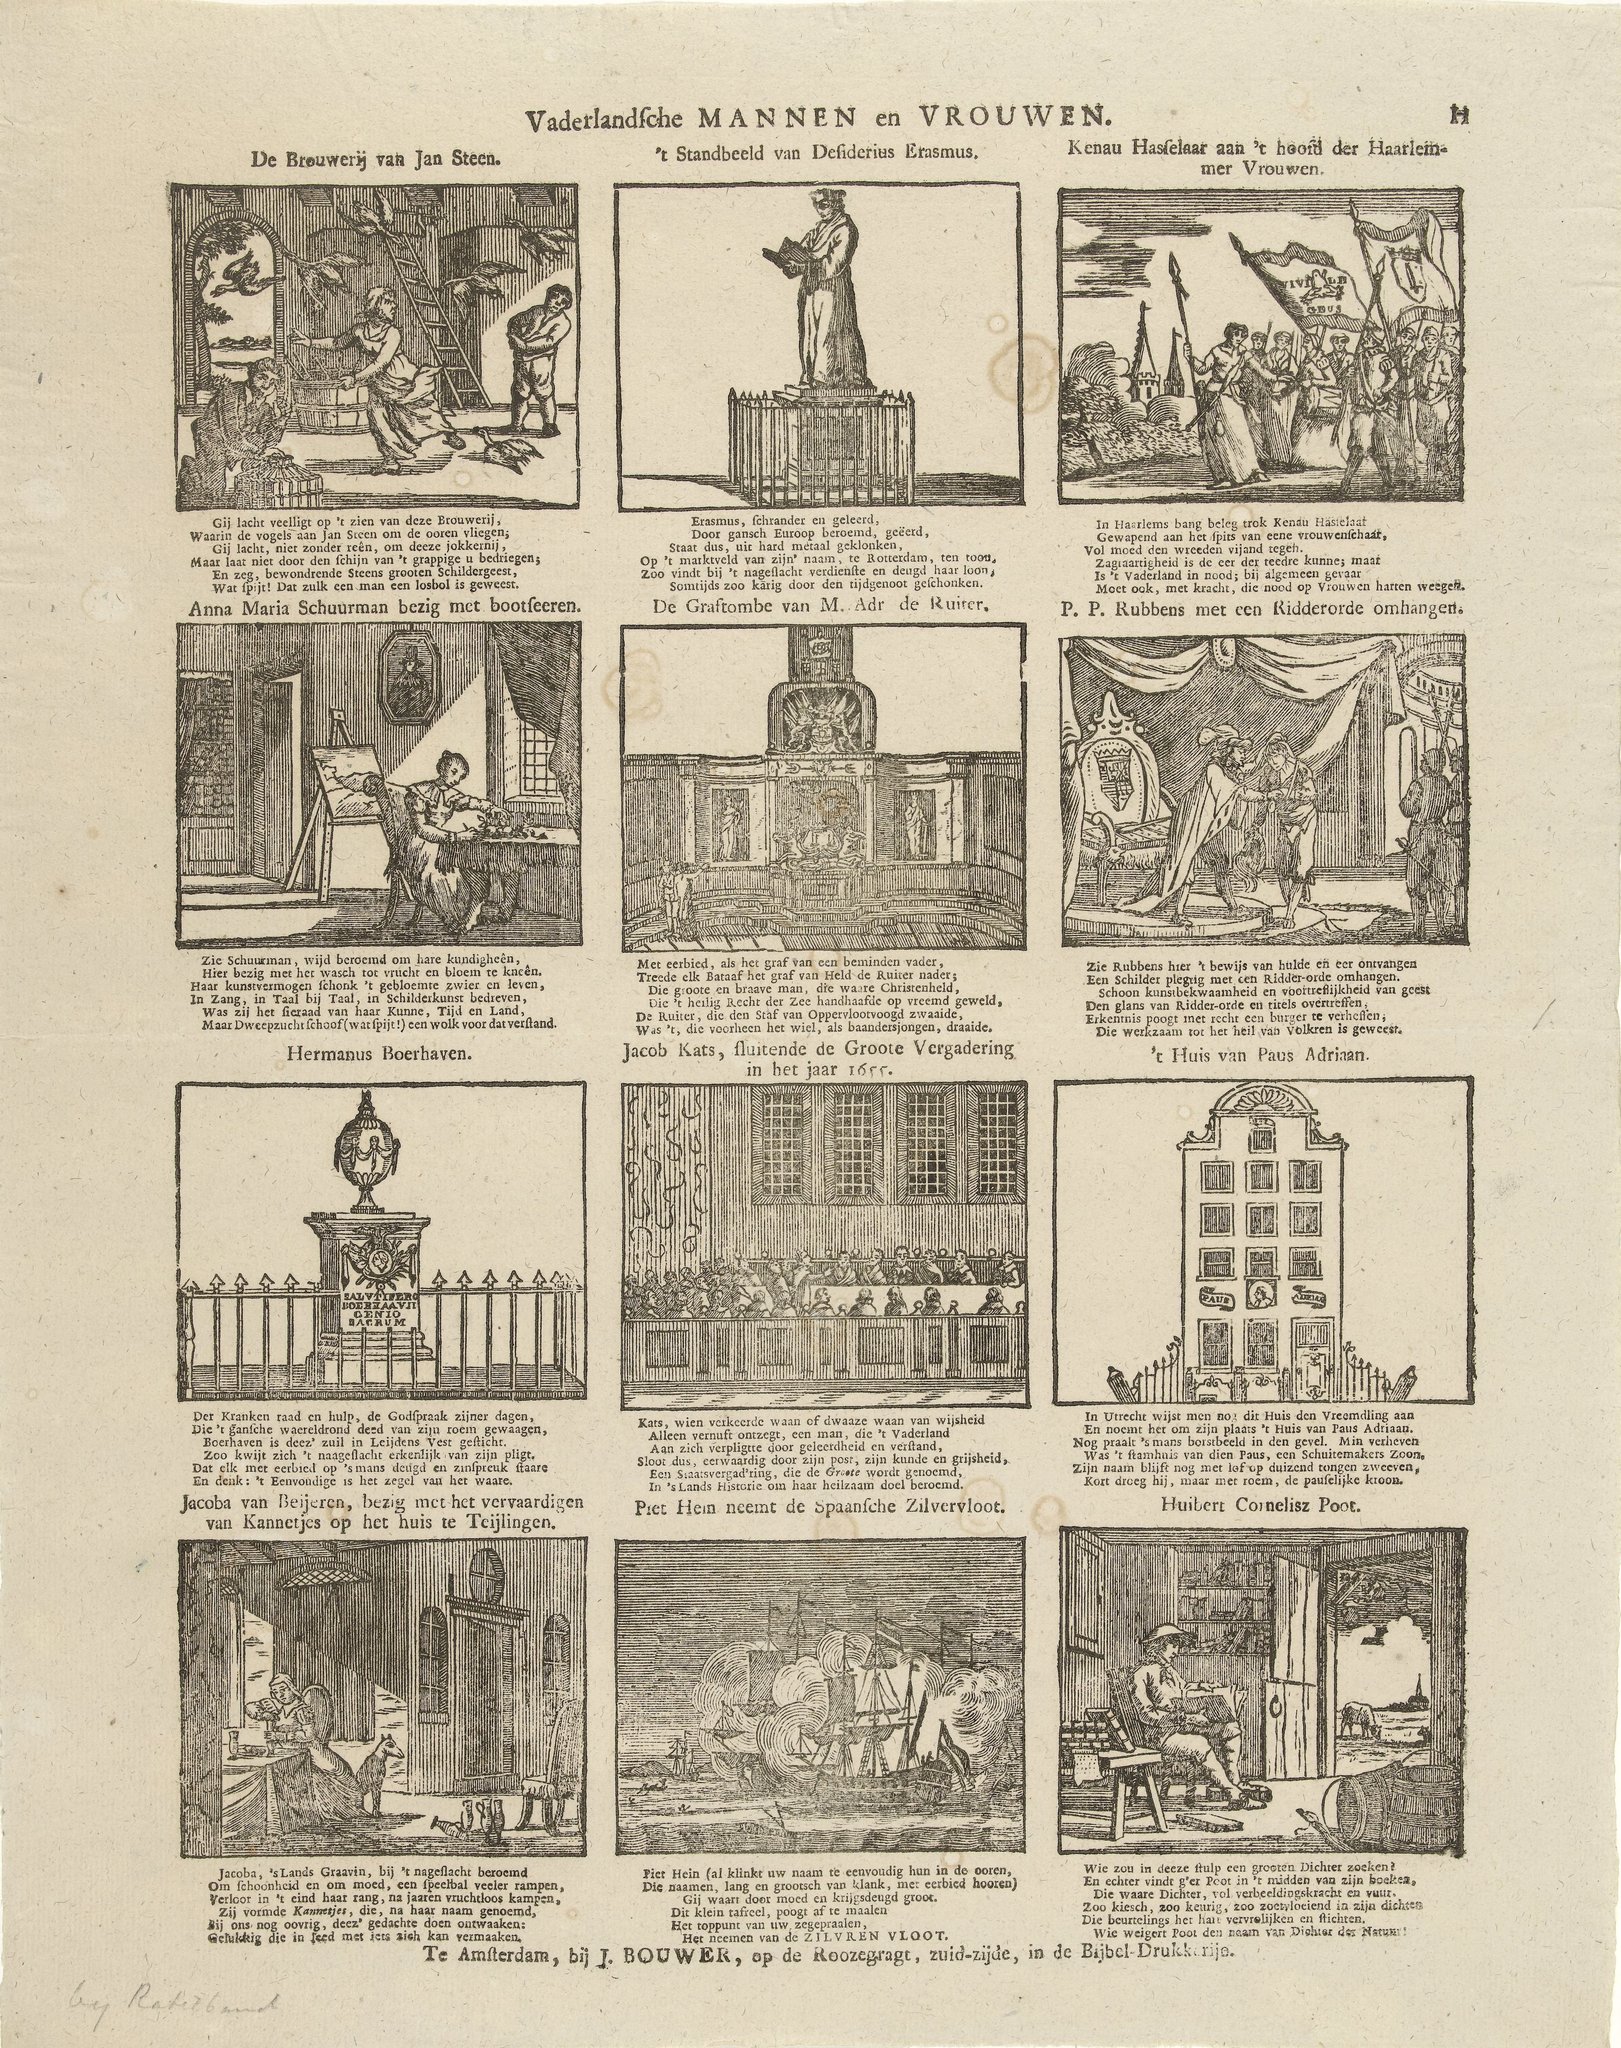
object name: popular print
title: Vaderlandsche mannen en vrouwen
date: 1805-1808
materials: paper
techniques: letterpress printing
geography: amsterdam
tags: cologne, anna maria van schurman, leiden, jan havicksz. steen, jacoba of bavaria (countess of hainaut), rotterdam, desiderius erasmus, flushing, michiel adriaenszoon de ruyter, delfshaven, the hague, jacob cats (1577-1660), delft, hubert kornelisz. poot, antwerp, painter, print maker, draughtsman, peter paul rubens, utrecht, rome, hermanus boerhaave, coin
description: Blad met 12 voorstellingen van of over beroemde Nederlandse mannen en vrouwen, historische figuren. Boven elke afbeelding een titel, onder elke afbeelding een zesregelig vers. Genummerd rechtsboven: H.